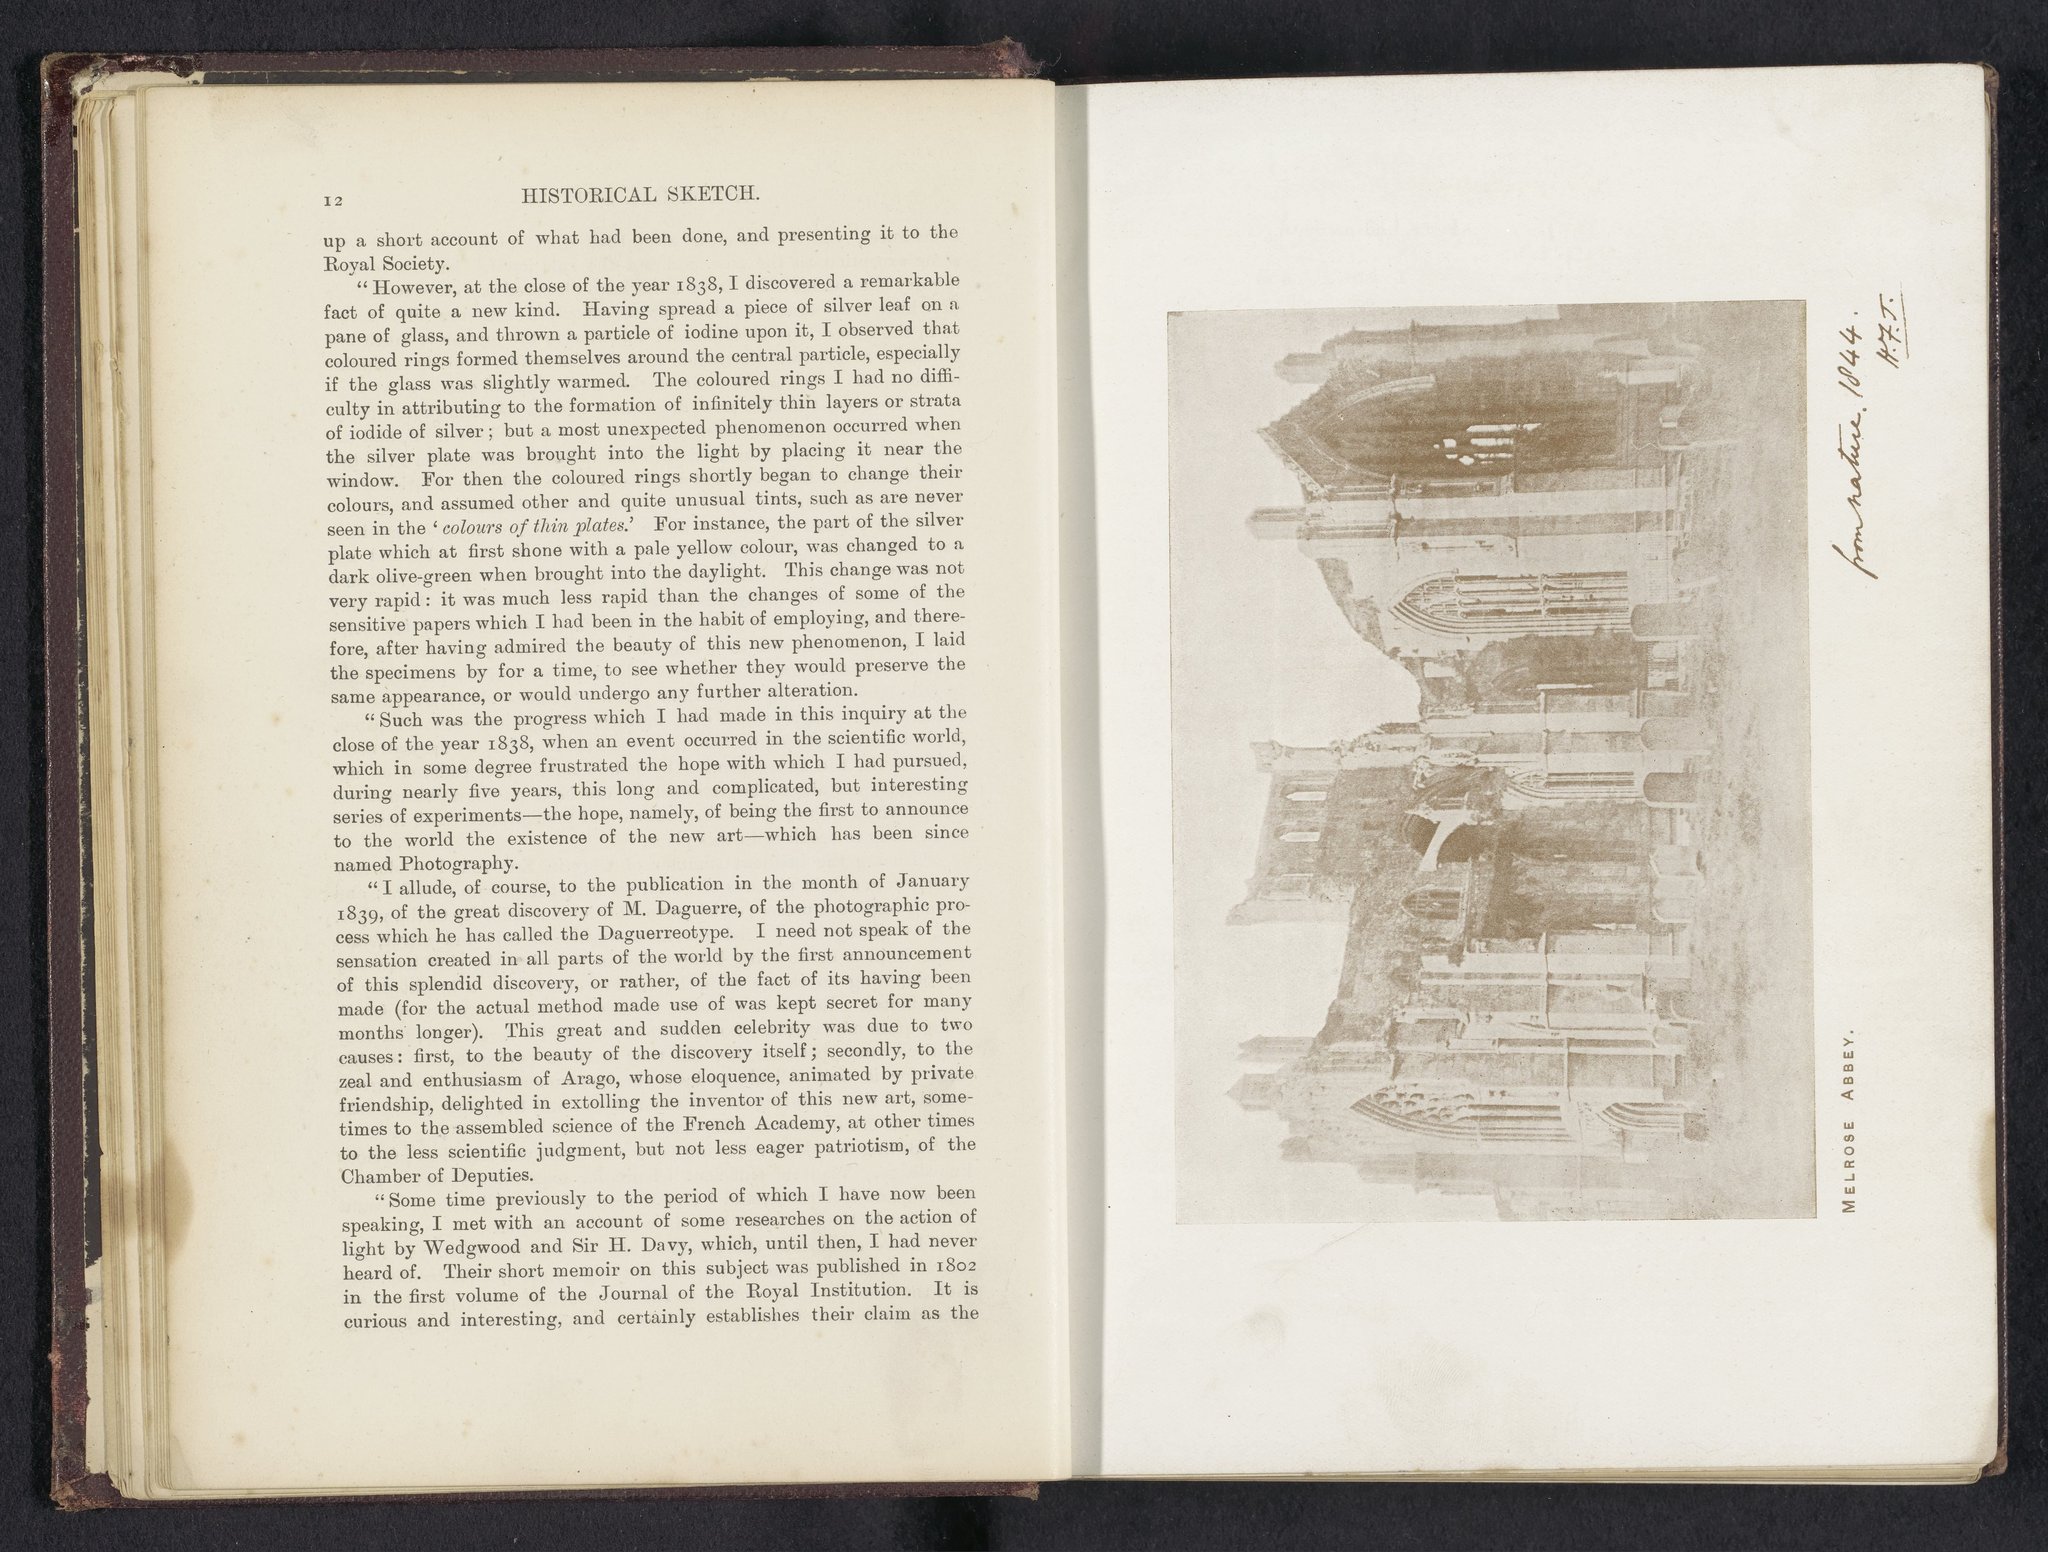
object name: reproduction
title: Melrose Abbey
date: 1889-1899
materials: paper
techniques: autotype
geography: scotland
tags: ruin of church, monastery, etc.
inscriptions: inscription: ‘from nature 1844. H.F.T.’